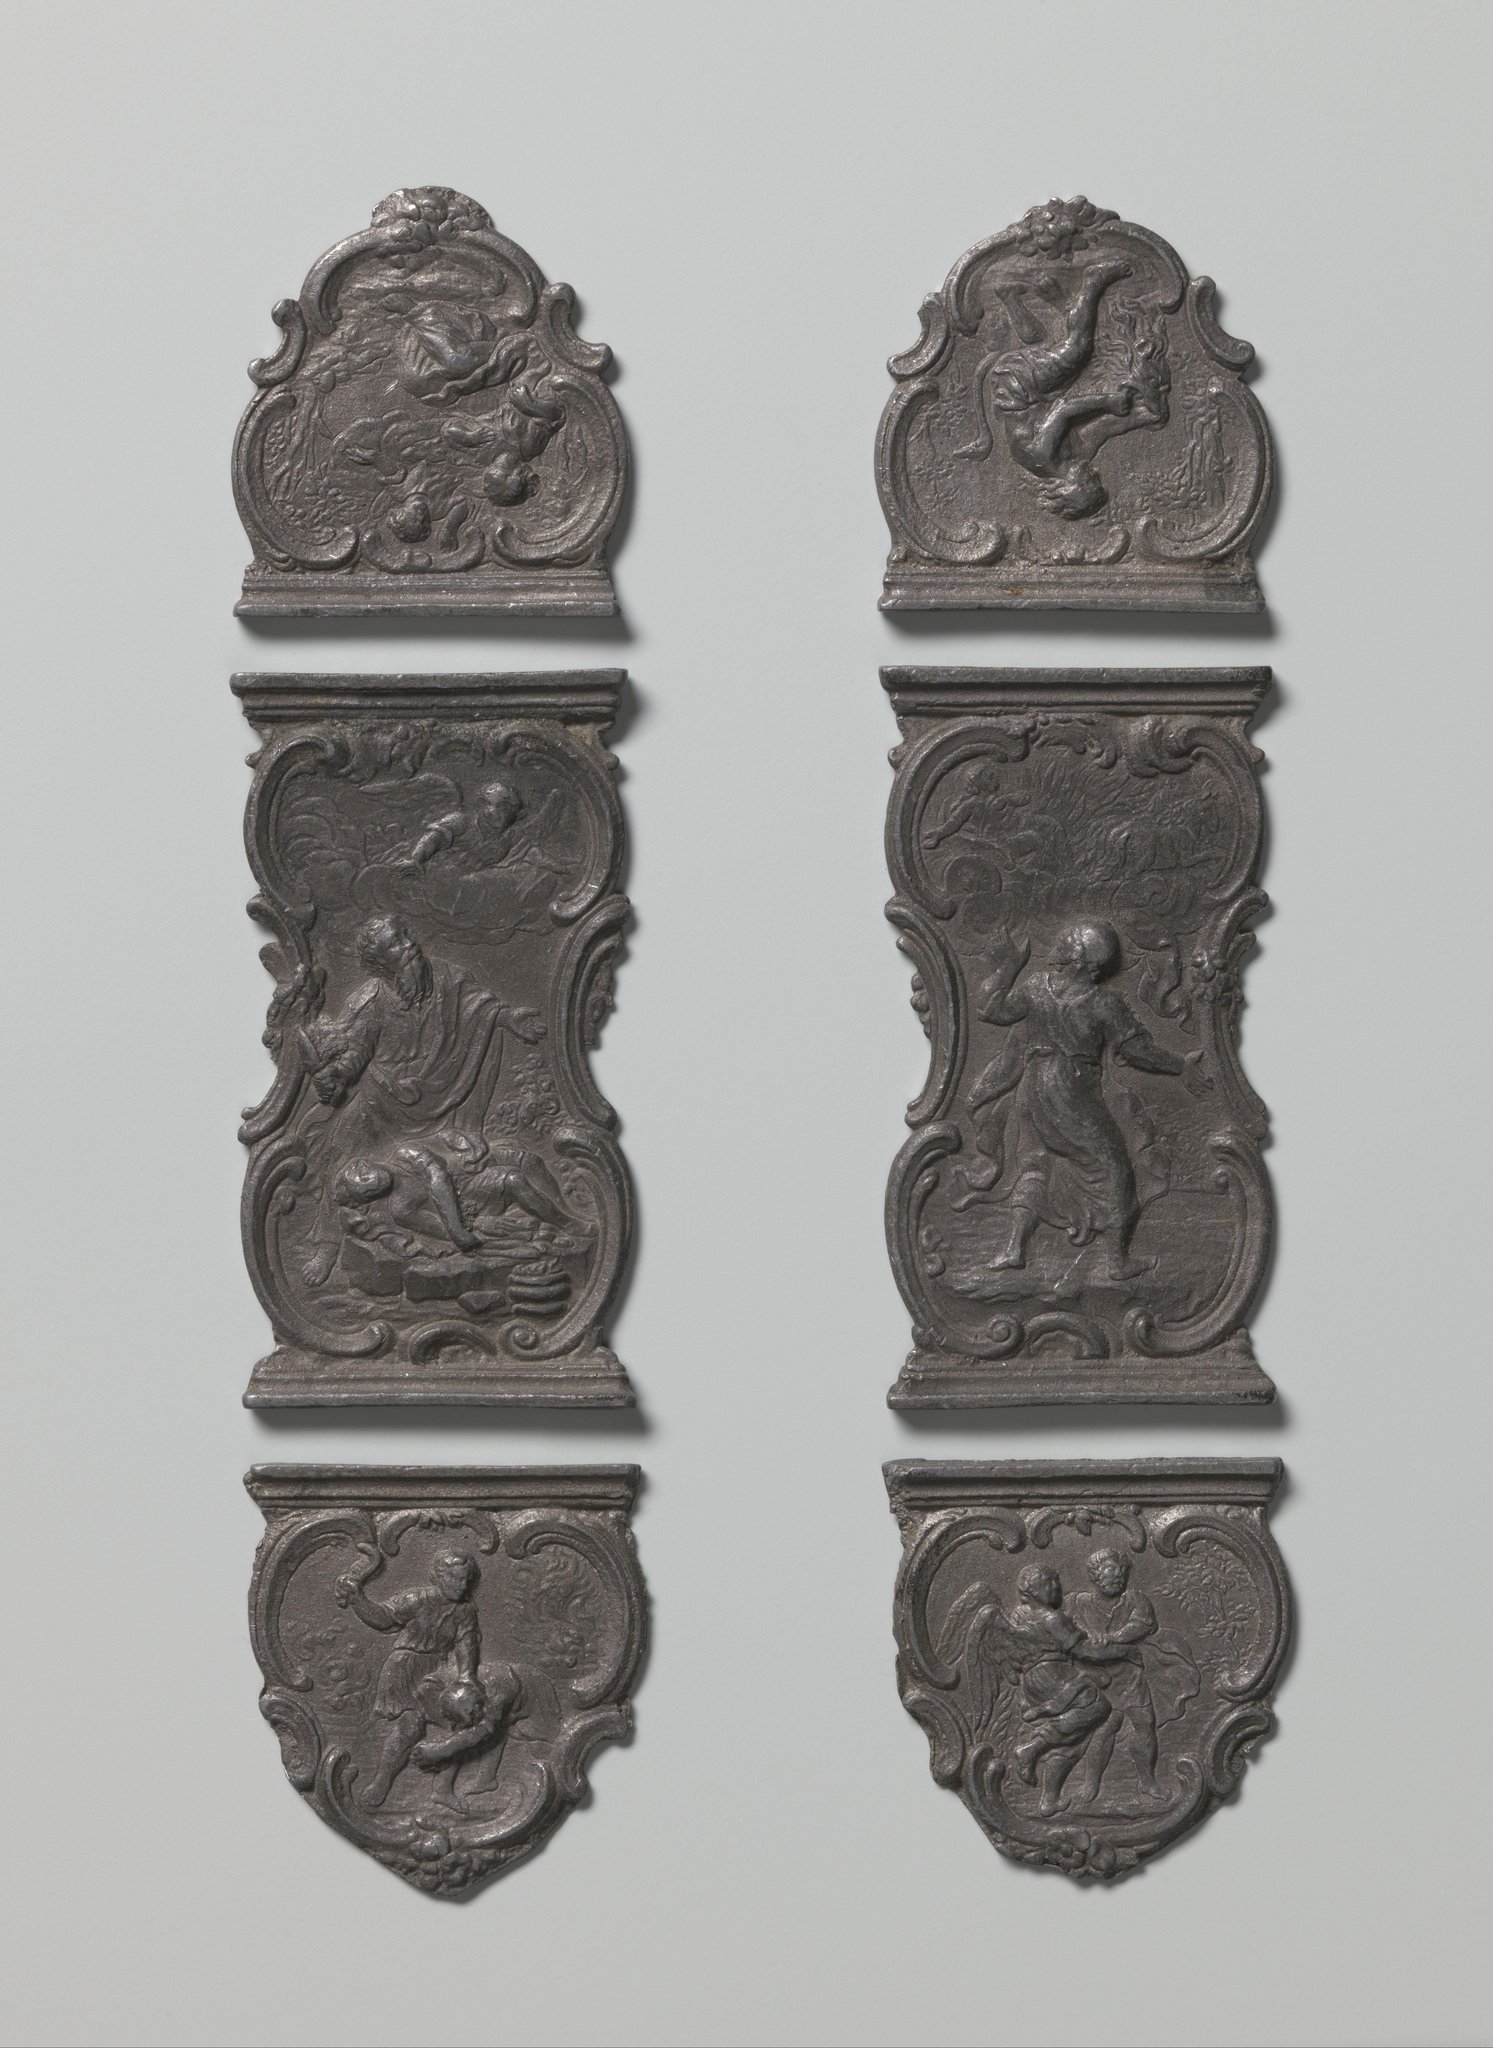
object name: klamp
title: Modellen voor klampen en beugels van boeksloten met voorstellingen uit het Oude Testament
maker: Anonymous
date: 1750-1775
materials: tin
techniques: metalworking, cutting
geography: amsterdam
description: Modellen van tin voor gietvormen van een klampen en beugels van boeksloten. Klamp (A) toont de voorstelling van Hagar en haar zoon Ismael in de woestijn en is gevat in een rococo-ornament, gevormd door drie grote, naar binnen gekeerde c-voluten en daartussen twee kleine, naar buiten gekeerde c-voluten. De bovenzijde is recht. Beugel (B) toont de voorstelling van de hemelvaart van Elia met de vurige wagen en is gevat in een rococo-ornament, gevormd door zes lange c-voluten, waarvan de middelste twee naar buiten zijn gekeerd, de andere vier zijn naar binnen gekeerd. De boven- en onderzijde zijn recht. Klamp (C) toont de voorstelling van Kaïn die Abel doodt en is gevat in een rococo-ornament, gevormd door drie grote, naar binnen gekeerde c-voluten en daartussen twee kleine, naar buiten gekeerde c-voluten. De bovenzijde is recht. Klamp (D) toont de voorstelling van Simson die de leeuw doodt en is gevat in een rococo-ornament, gevormd door drie grote, naar binnen gekeerde c-voluten en daartussen twee kleine, naar buiten gekeerde c-voluten. De bovenzijde is recht. Beugel (E) toont de voorstelling van Abraham die op het punt staat zijn zoon Izaäk te offeren en is gevat in een rococo-ornament, gevormd door zes lange c-voluten, waarvan de middelste twee naar buiten zijn gekeerd, de overige vier zijn naar binnen gekeerd. De boven- en onderzijde zijn recht. Klamp (F) toont de voorstelling van Jacob met de engel en is gevat in een rococo-ornament, gevormd door drie grote, naar binnen gekeerde c-voluten en daartussen twee kleine, naar buiten gekeerde c-voluten. De bovenzijde is recht.